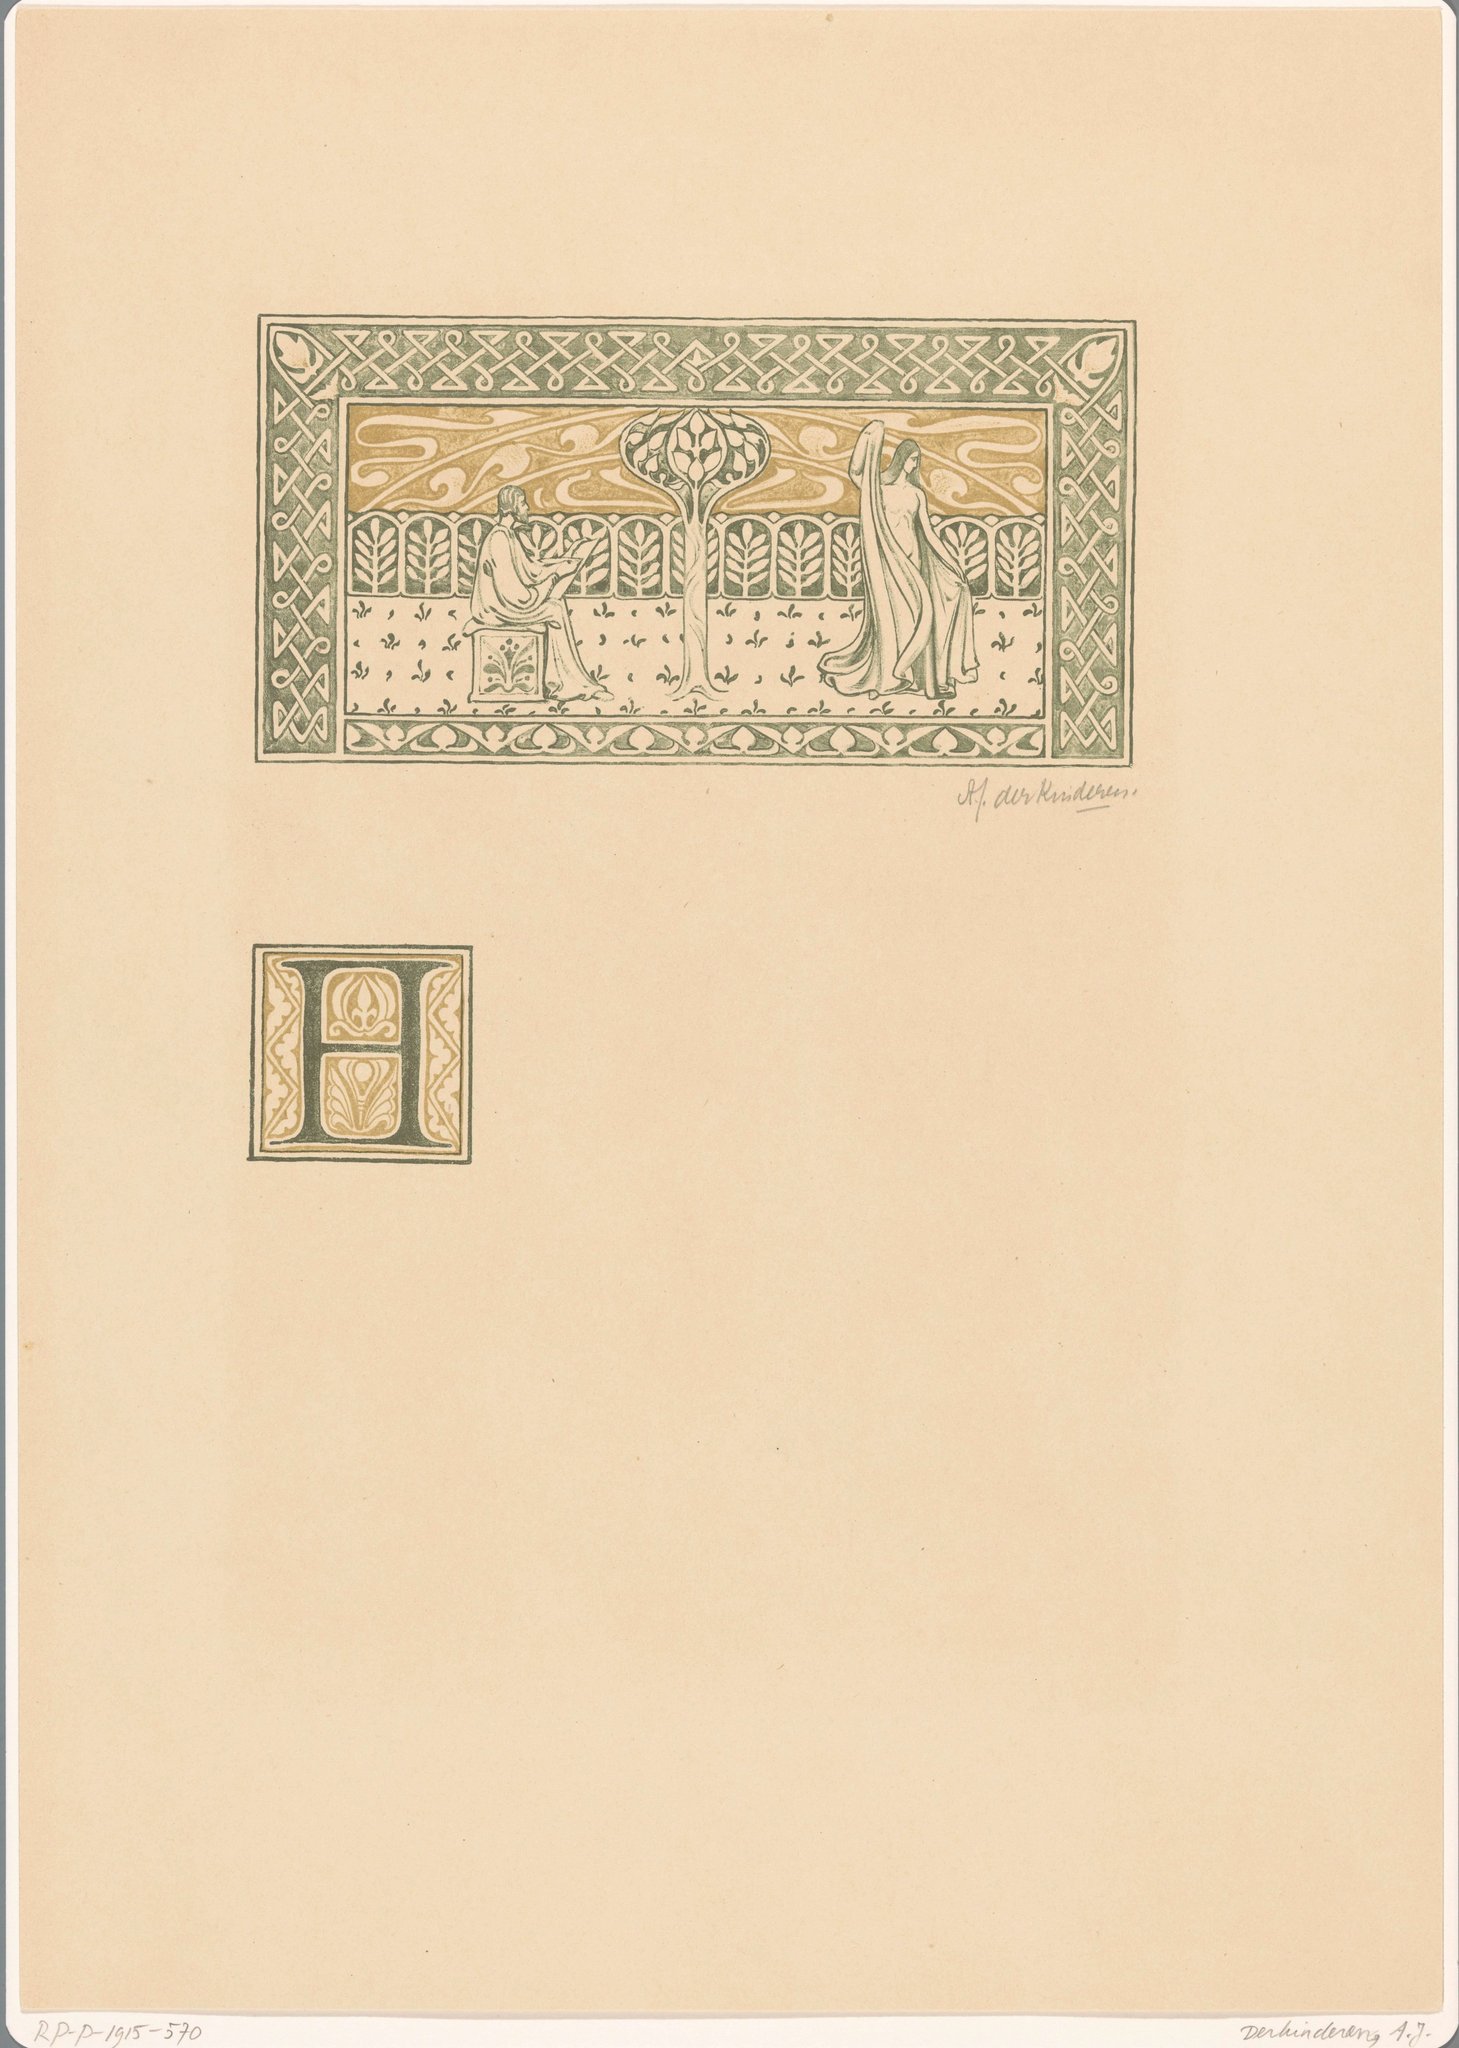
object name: book illustration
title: Hoofdletter H en vignet met twee figuren in een tuin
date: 1896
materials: paper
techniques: lithograph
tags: initial, garden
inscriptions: collector's mark: Lugt 2233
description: De hoofdletter is omgeven door een vierkant kader. De restvormen zijn ingevuld met plantmotieven. Boven de hoofdletter een zittende en staande figuur in een tuin met een boom, omgeven door een rechthoekige sierrand. De zittende figuur schrijft of tekent op een vel papier.